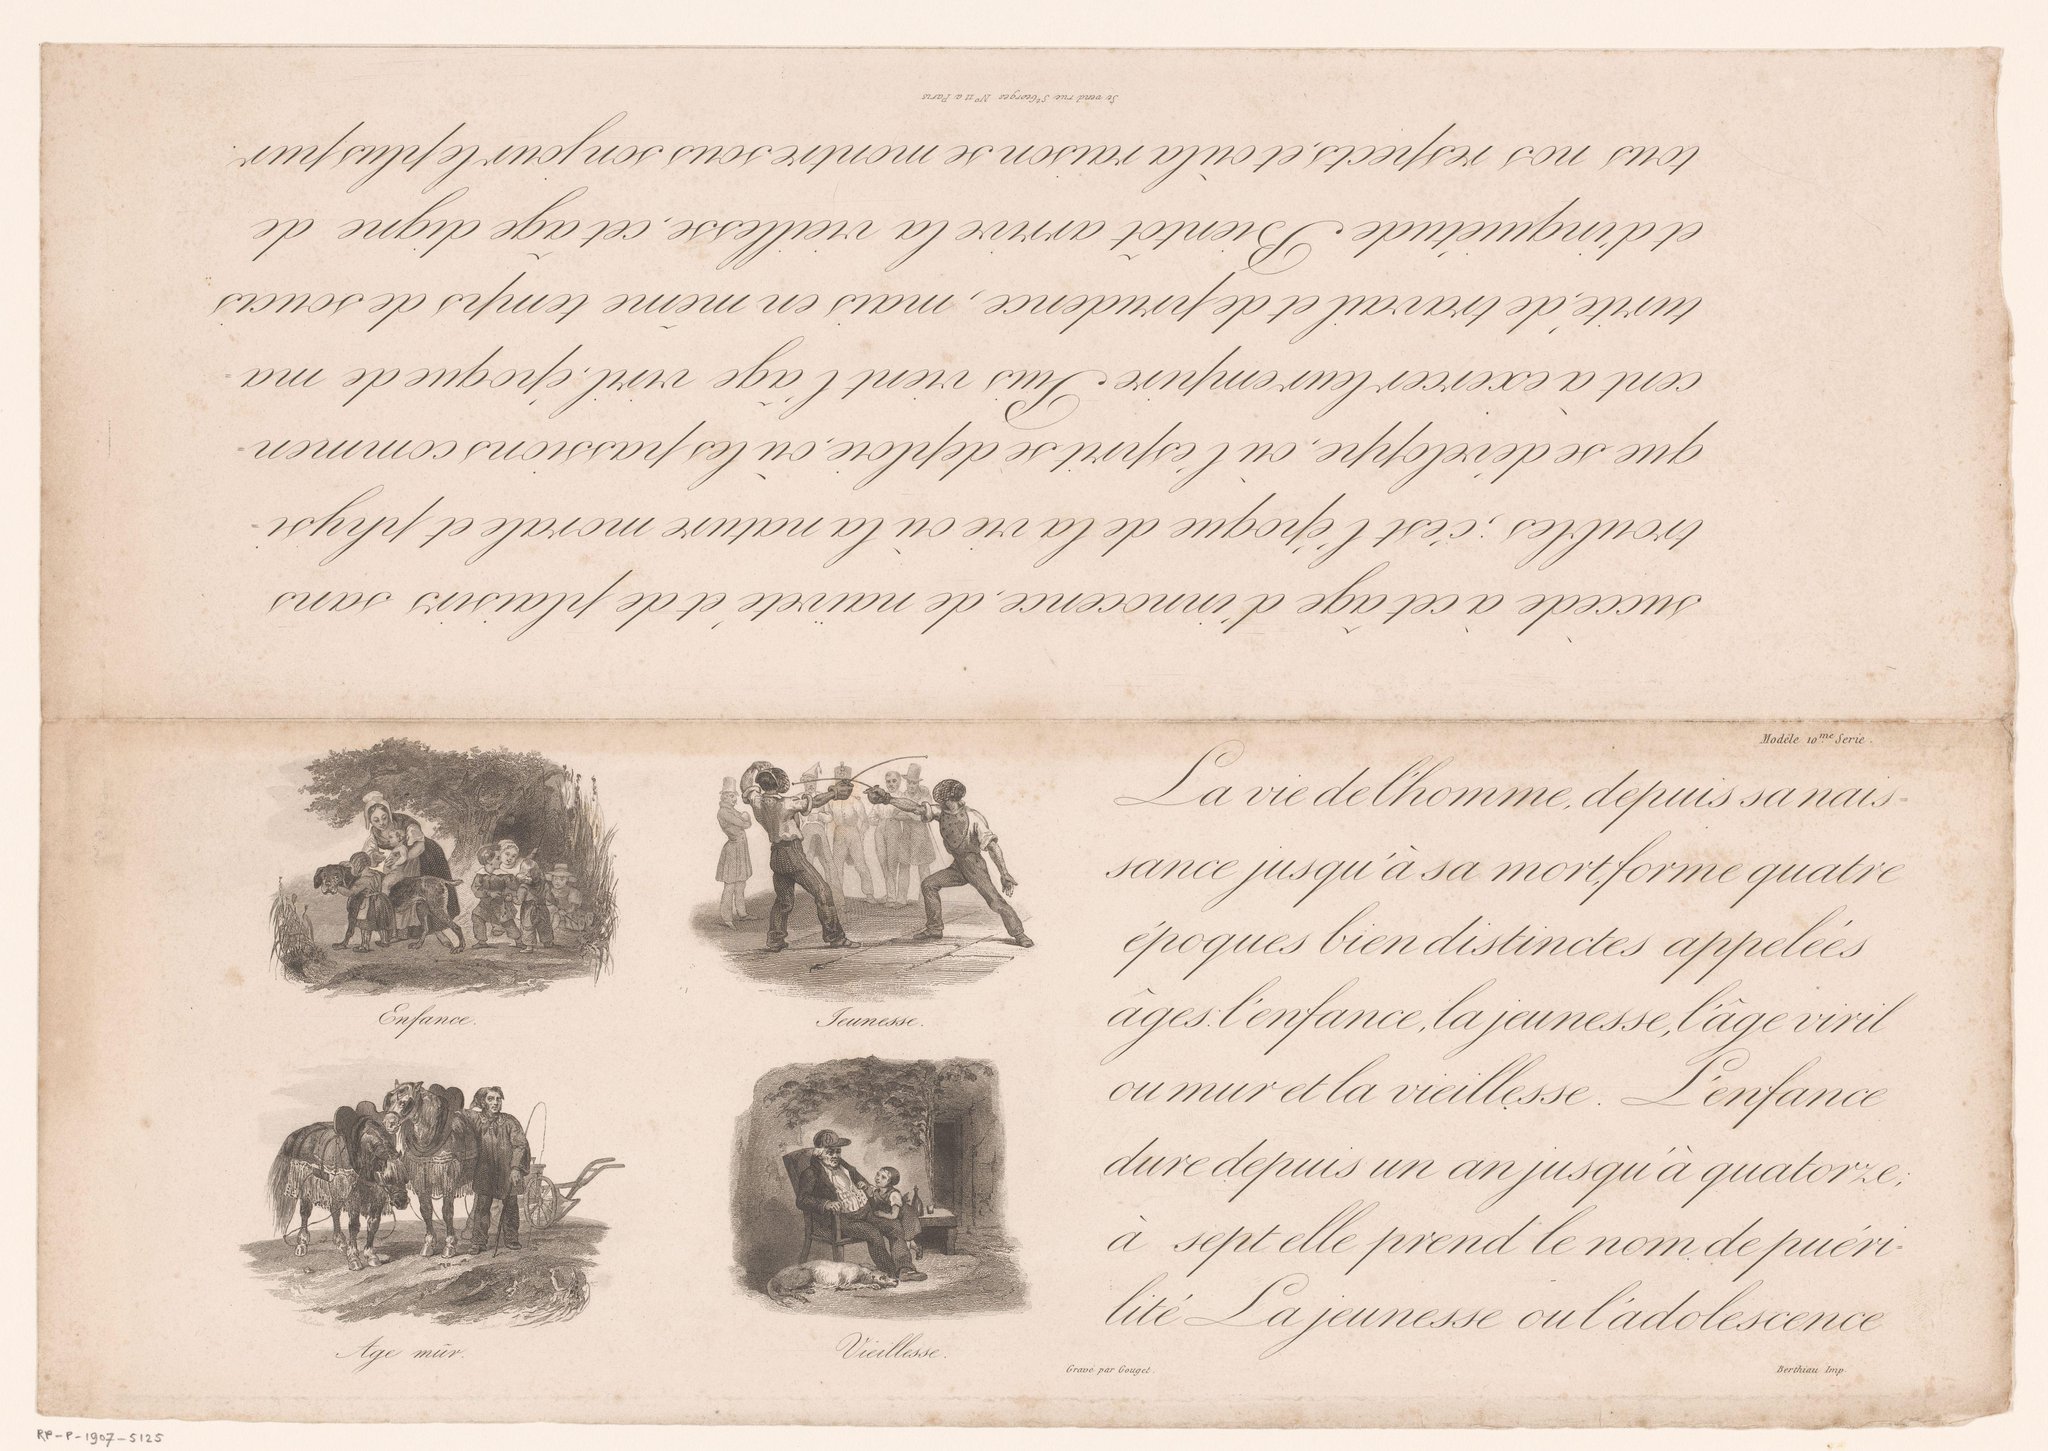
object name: print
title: Vier leeftijden van de mens met beschrijvende tekst van twee kanten te lezen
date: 1800-1899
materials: paper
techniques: engraving, etching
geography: paris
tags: the ages of man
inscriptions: collector's mark: Lugt 2228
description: Vier leeftijden van de mens van links naar rechts en van boven naar beneden: kindertijd (Enfance), jeugd (Jeunesse), volwassenheid (Age mur) en ouderdom (Viellesse), met beschrijvende tekst van twee kanten te lezen.